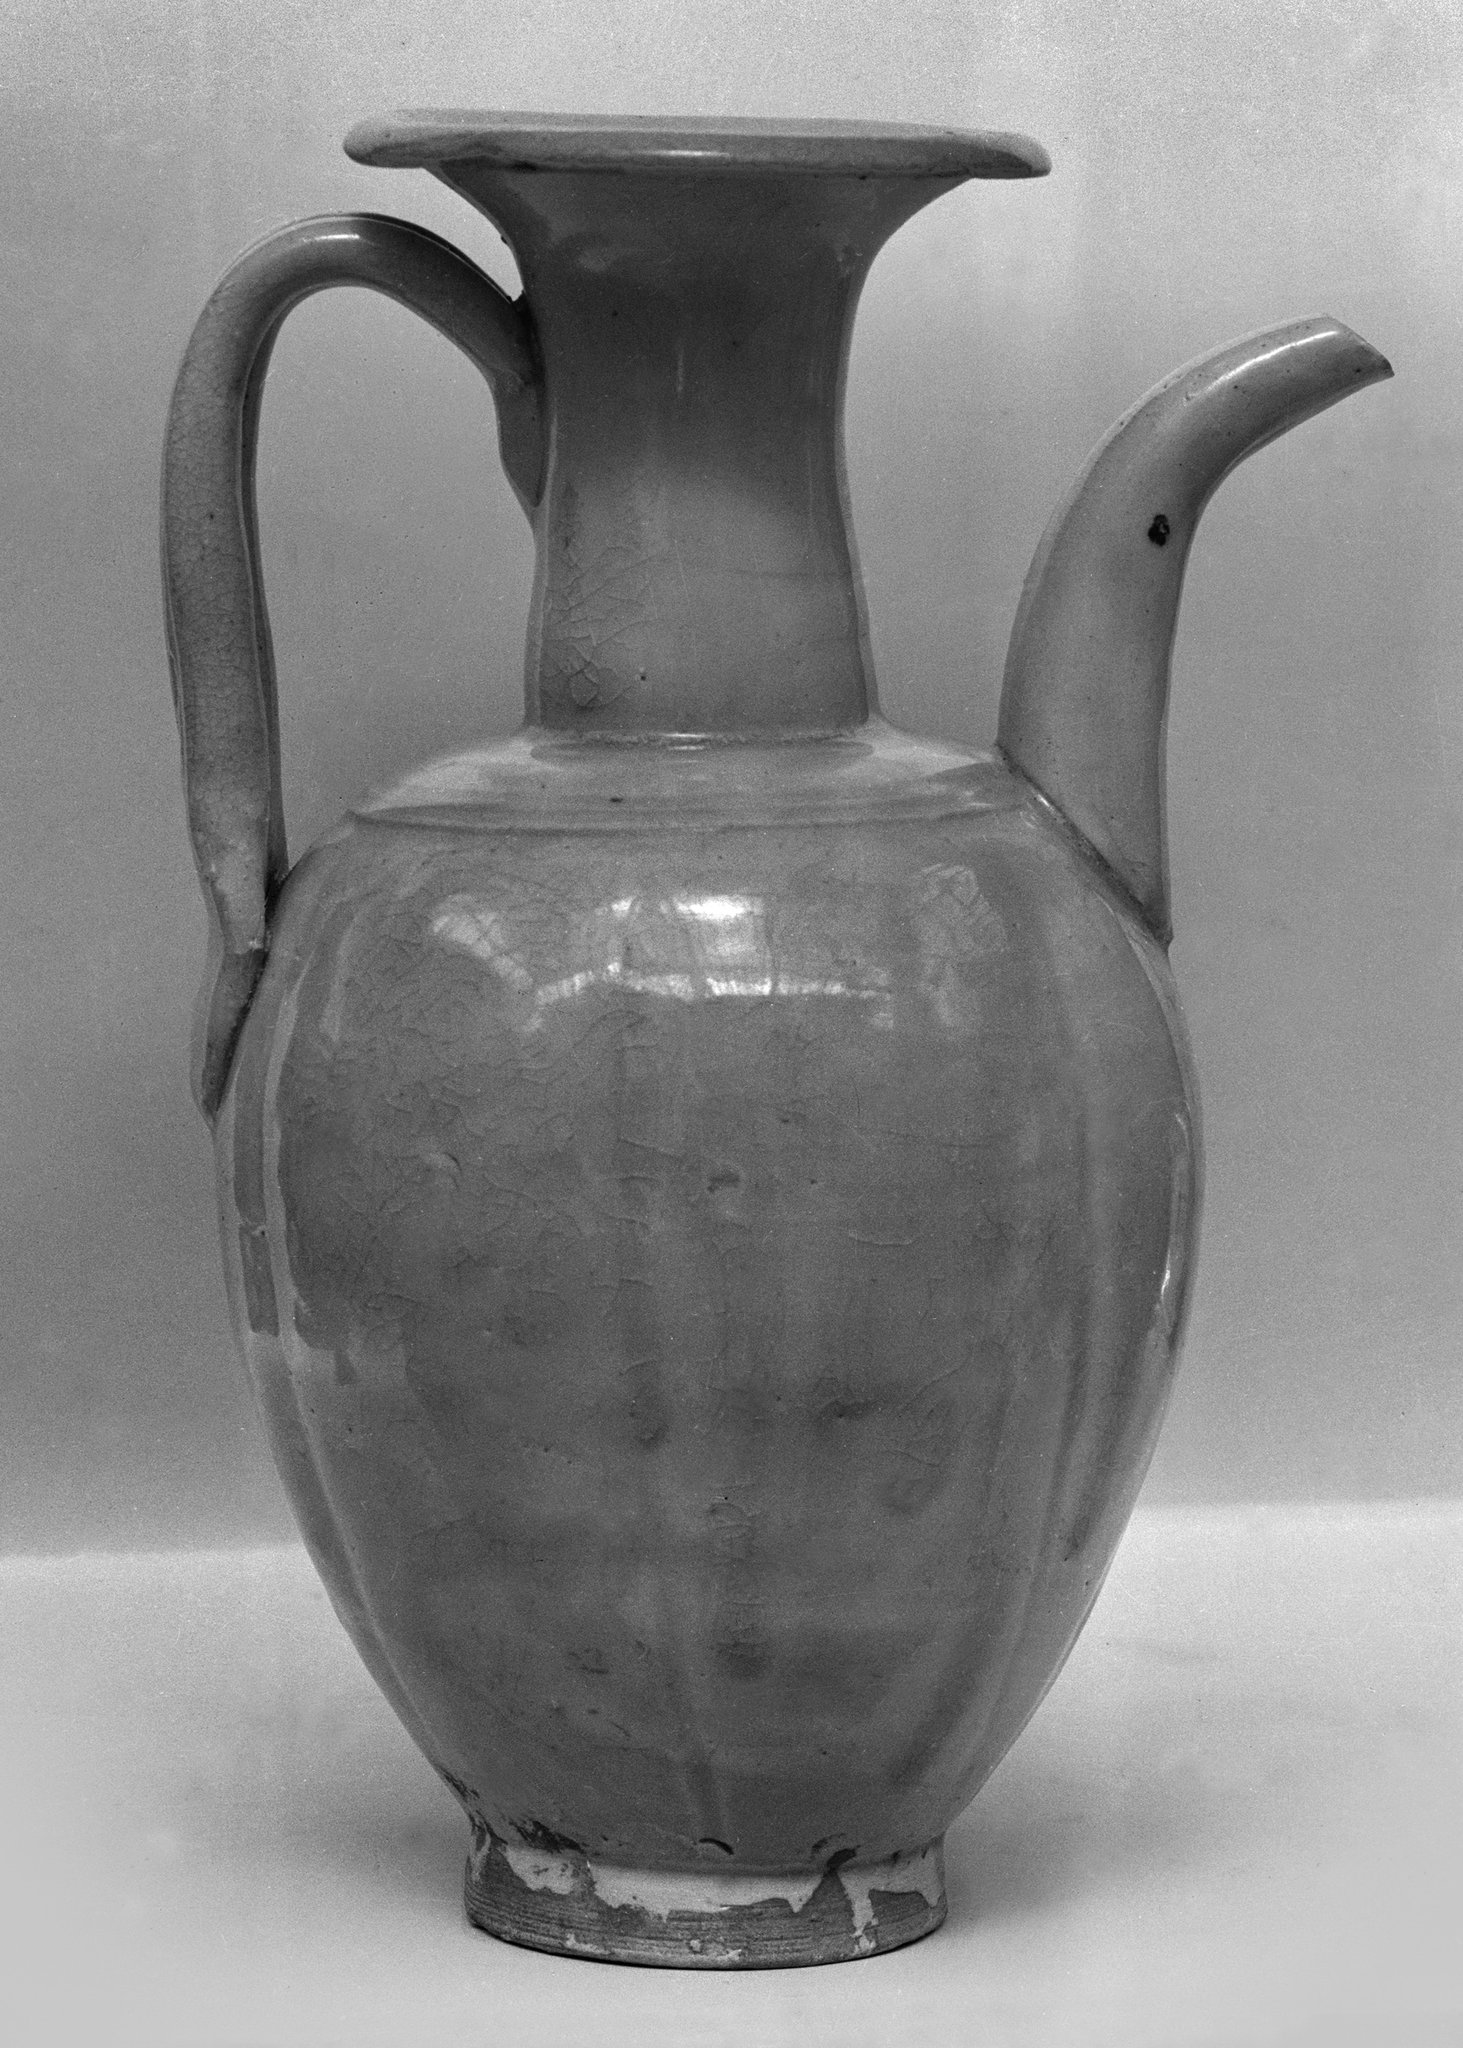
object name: wine pot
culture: korean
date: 1201-1300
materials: clay